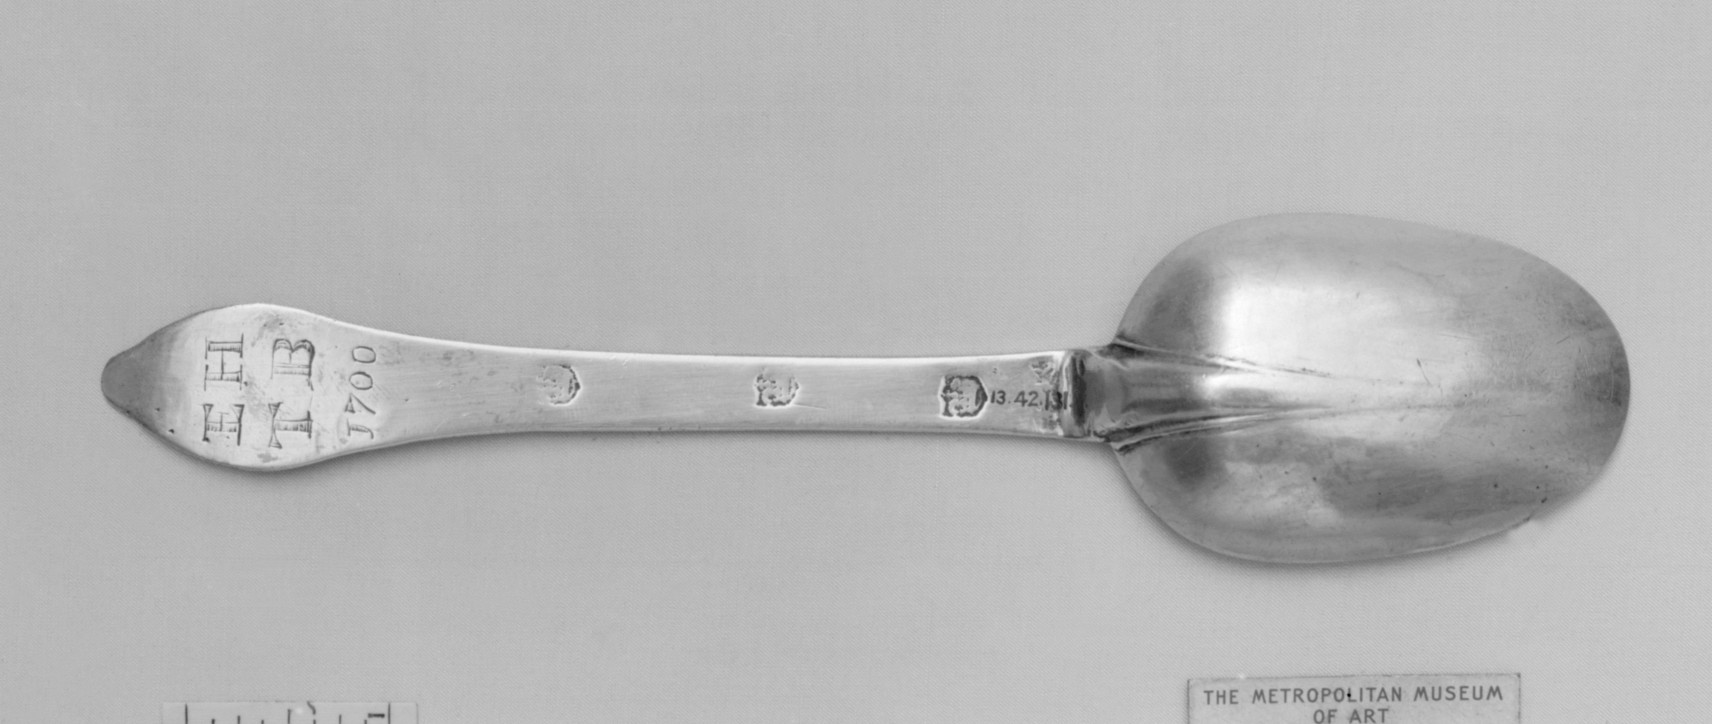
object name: spoon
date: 1685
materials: silver